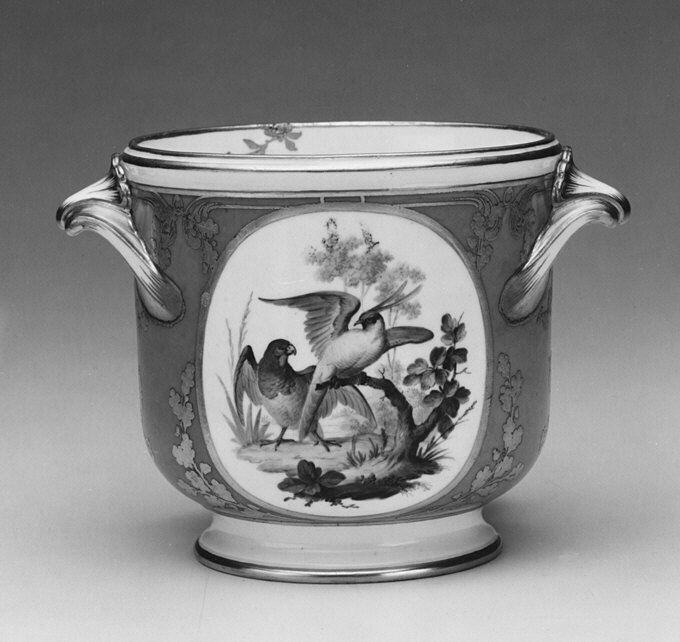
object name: wine cooler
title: Wine cooler (seau à demi-bouteille) (one of two) (part of a service)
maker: sèvres manufactory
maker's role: manufactory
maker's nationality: french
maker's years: 1740-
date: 1771-1772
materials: soft paste porcelain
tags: birds,trees